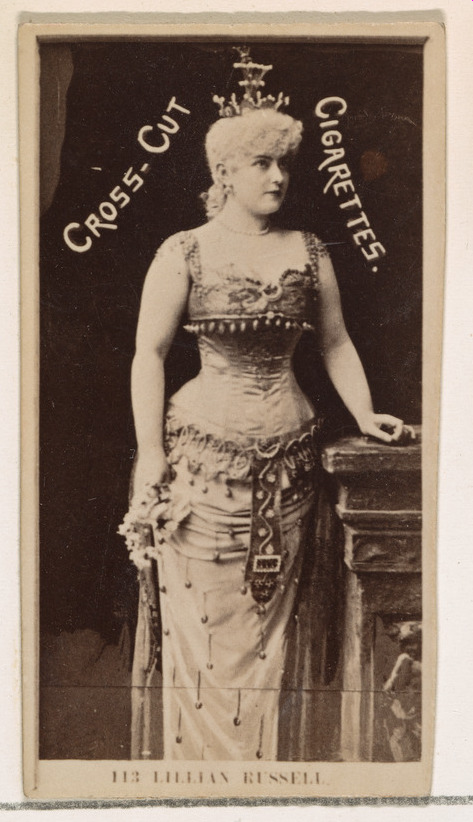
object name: print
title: Card Number 113, Lillian Russell, from the Actors and Actresses series (N145-2) issued by Duke Sons & Co. to promote Cross Cut Cigarettes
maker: w. duke, sons & co.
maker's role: publisher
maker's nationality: american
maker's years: 1870-1920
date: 1880-1889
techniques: albumen silver print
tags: portraits,women,actresses